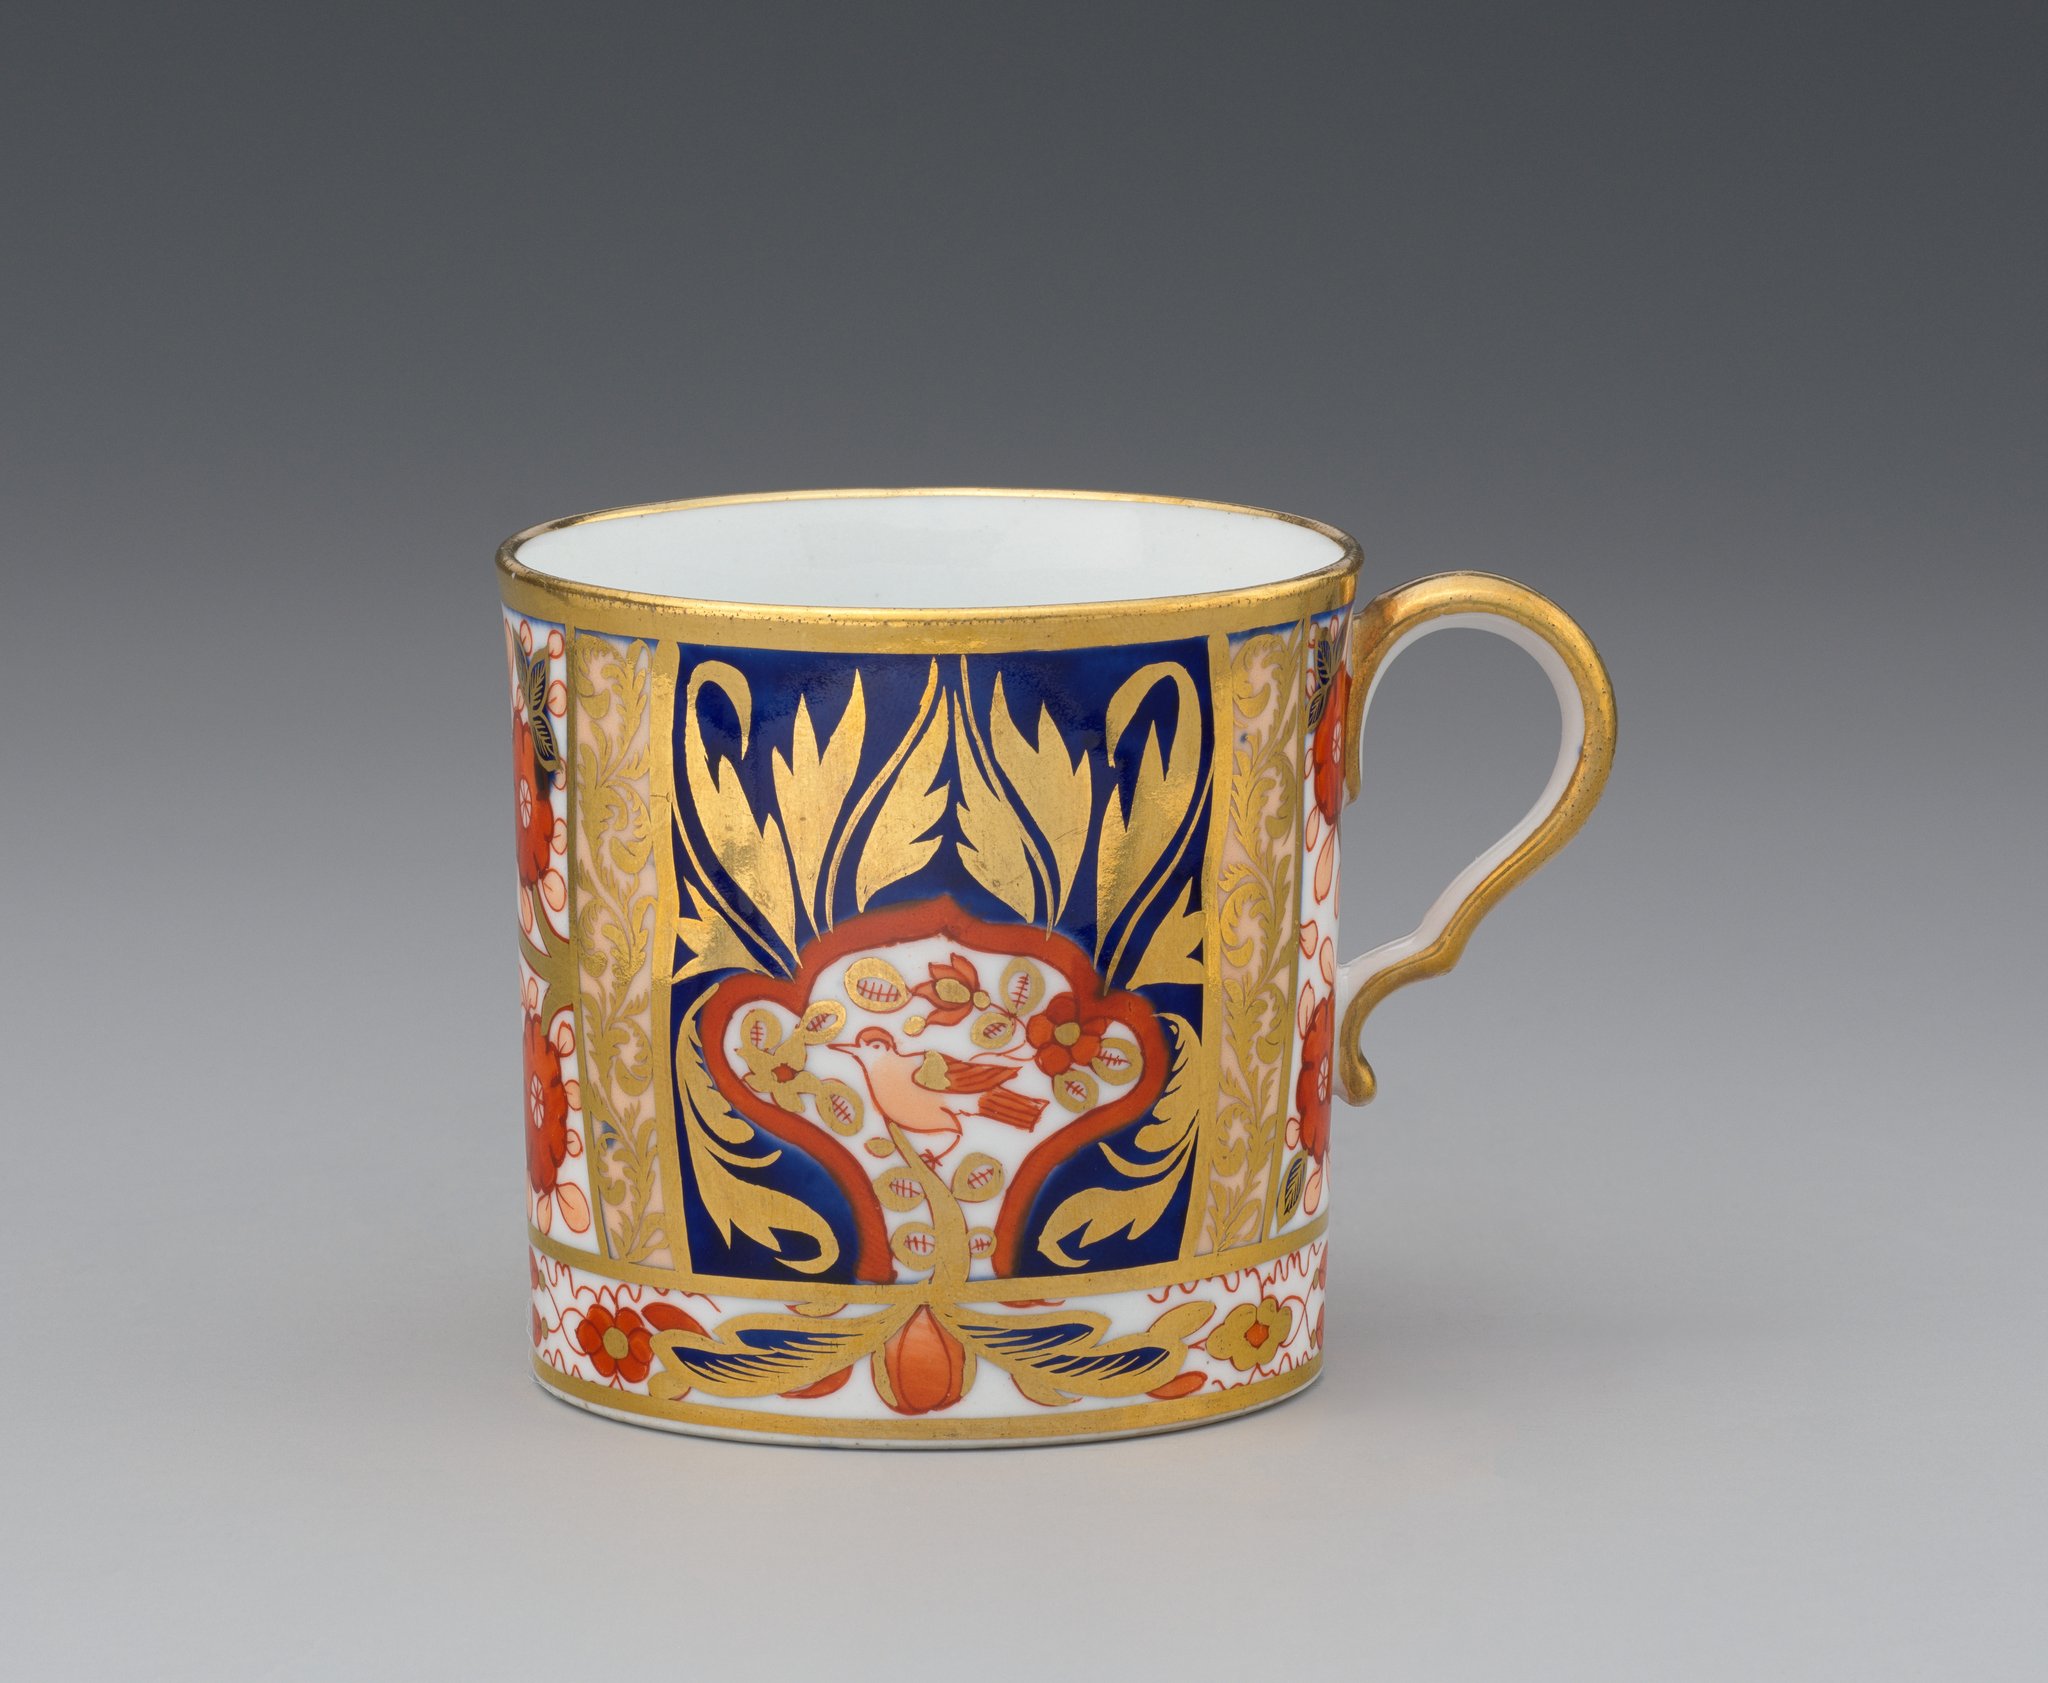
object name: cup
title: Cup (part of a service)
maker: j. spode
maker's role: factory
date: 1800-1830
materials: soft paste porcelain